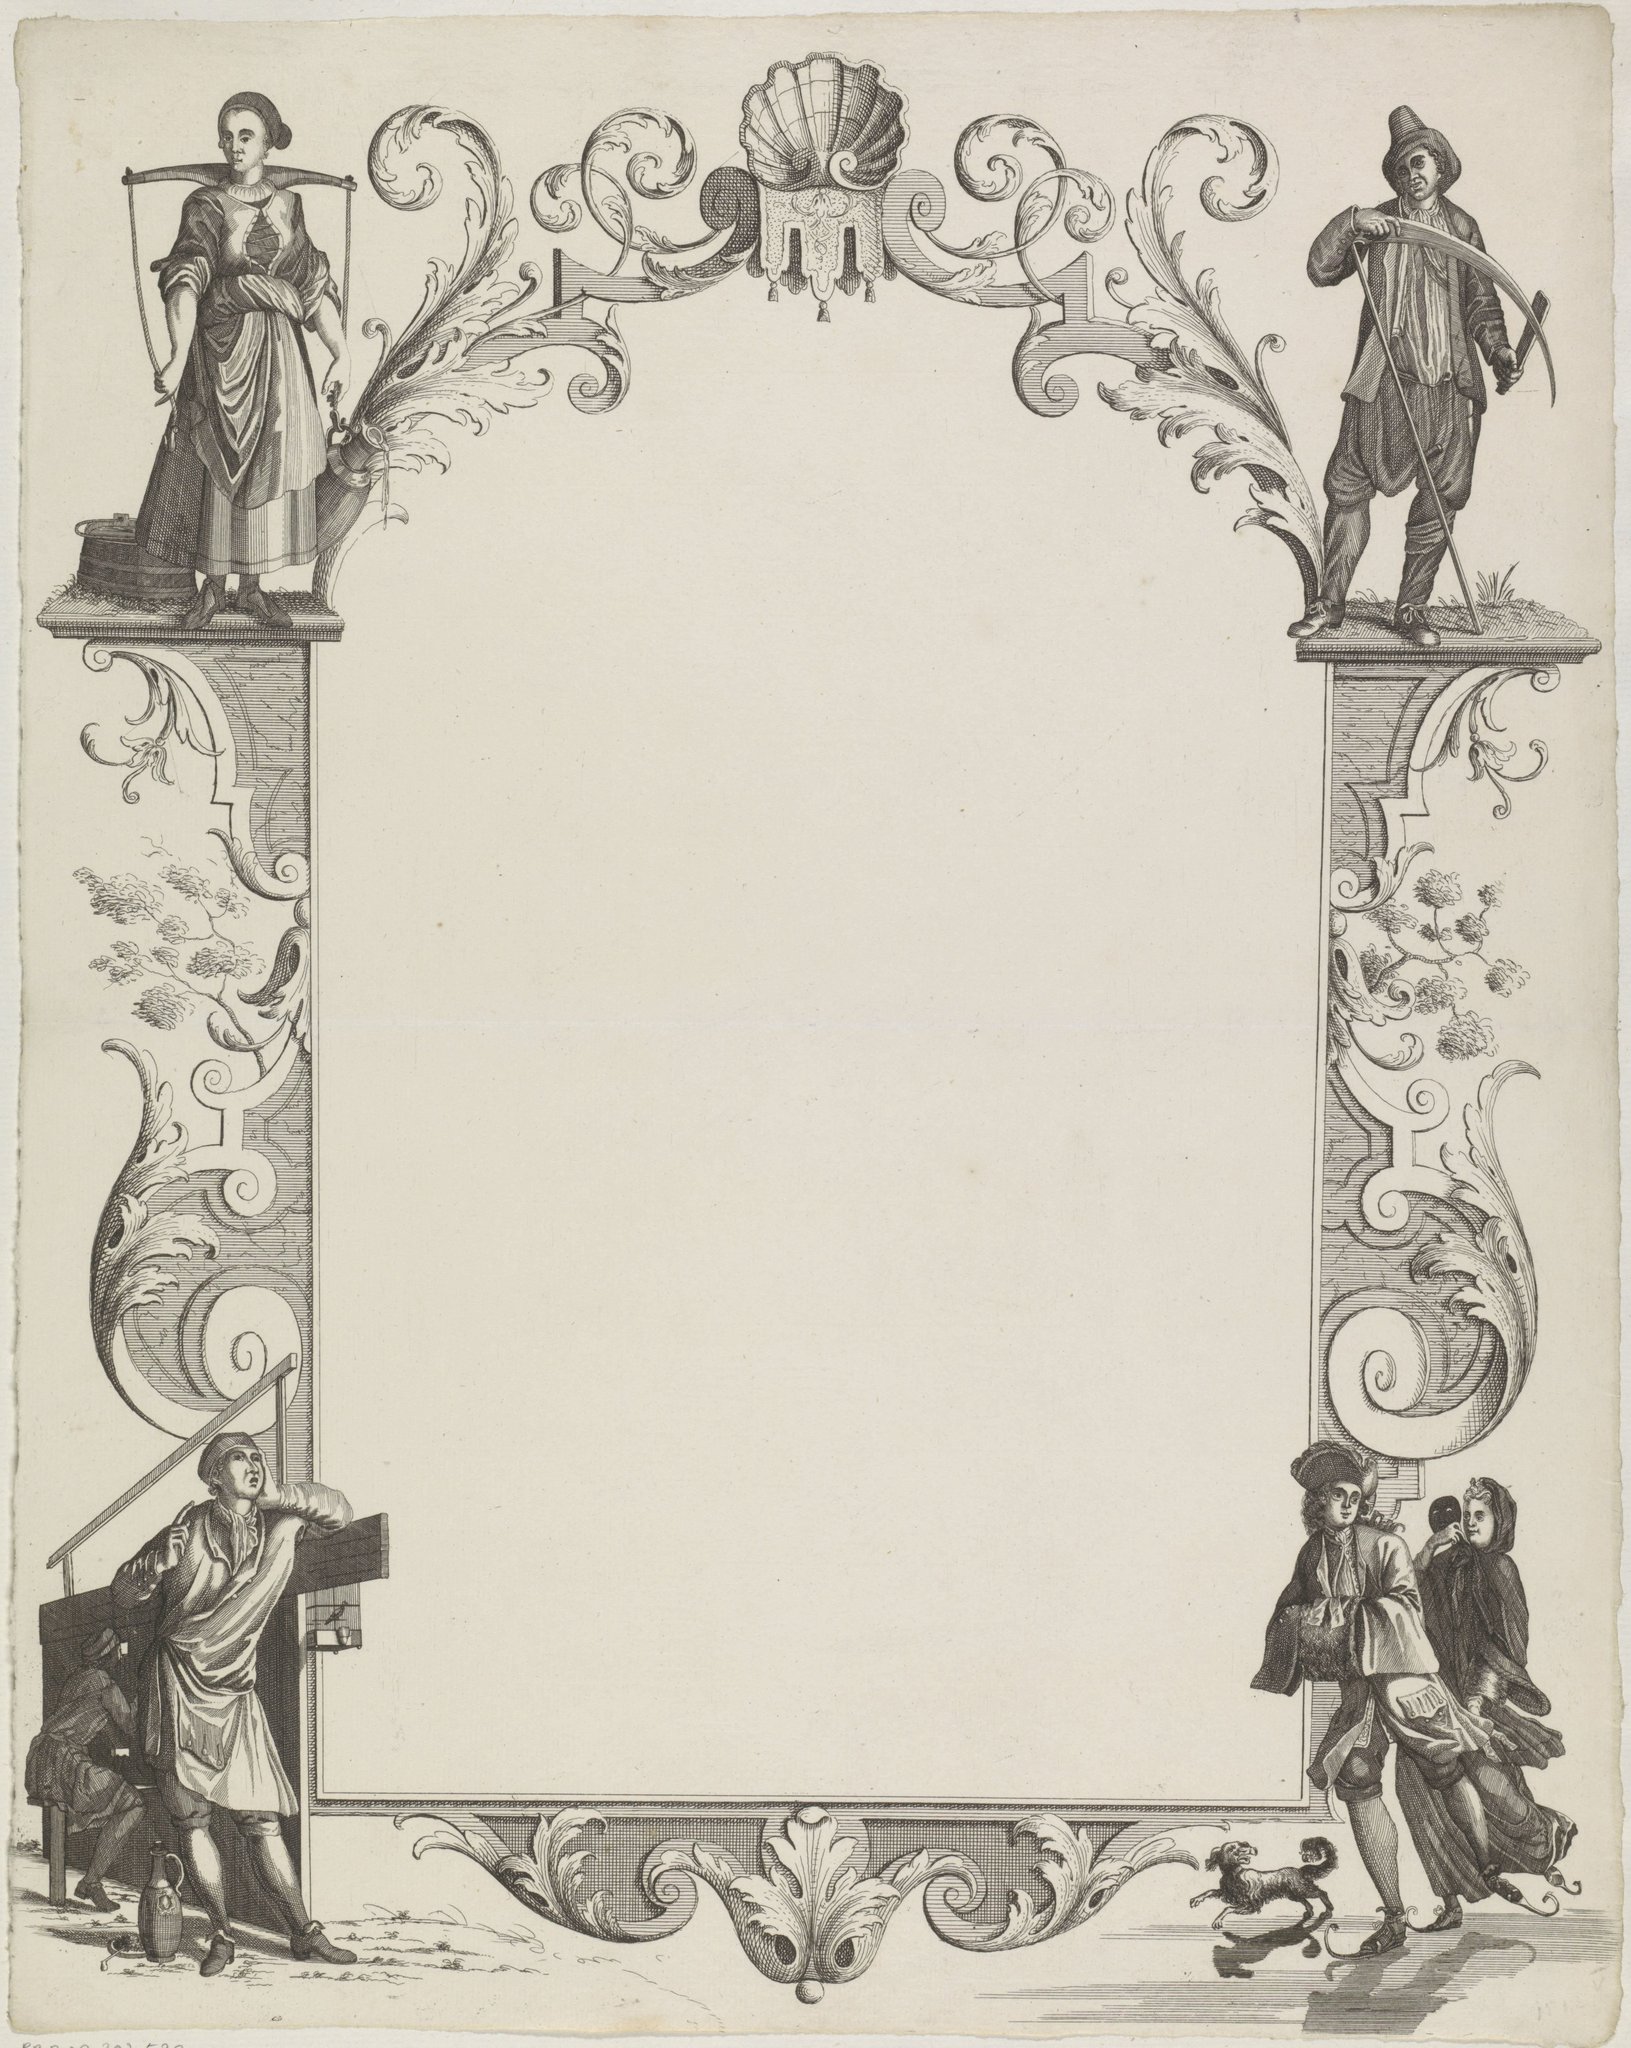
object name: wensbrief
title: Wensbrief met verschillende figuren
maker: Anonymous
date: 1700-1899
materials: paper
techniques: etching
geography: netherlands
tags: human types, characters (human types), skates (winter sports), milkmaid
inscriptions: collector's mark: Lugt 2760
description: Wensbrief met onbeschreven cartouche binnen een decoratief kader met voorstellingen van verschillende figuren, waaronder schaatsende mensen en een melkmeid.